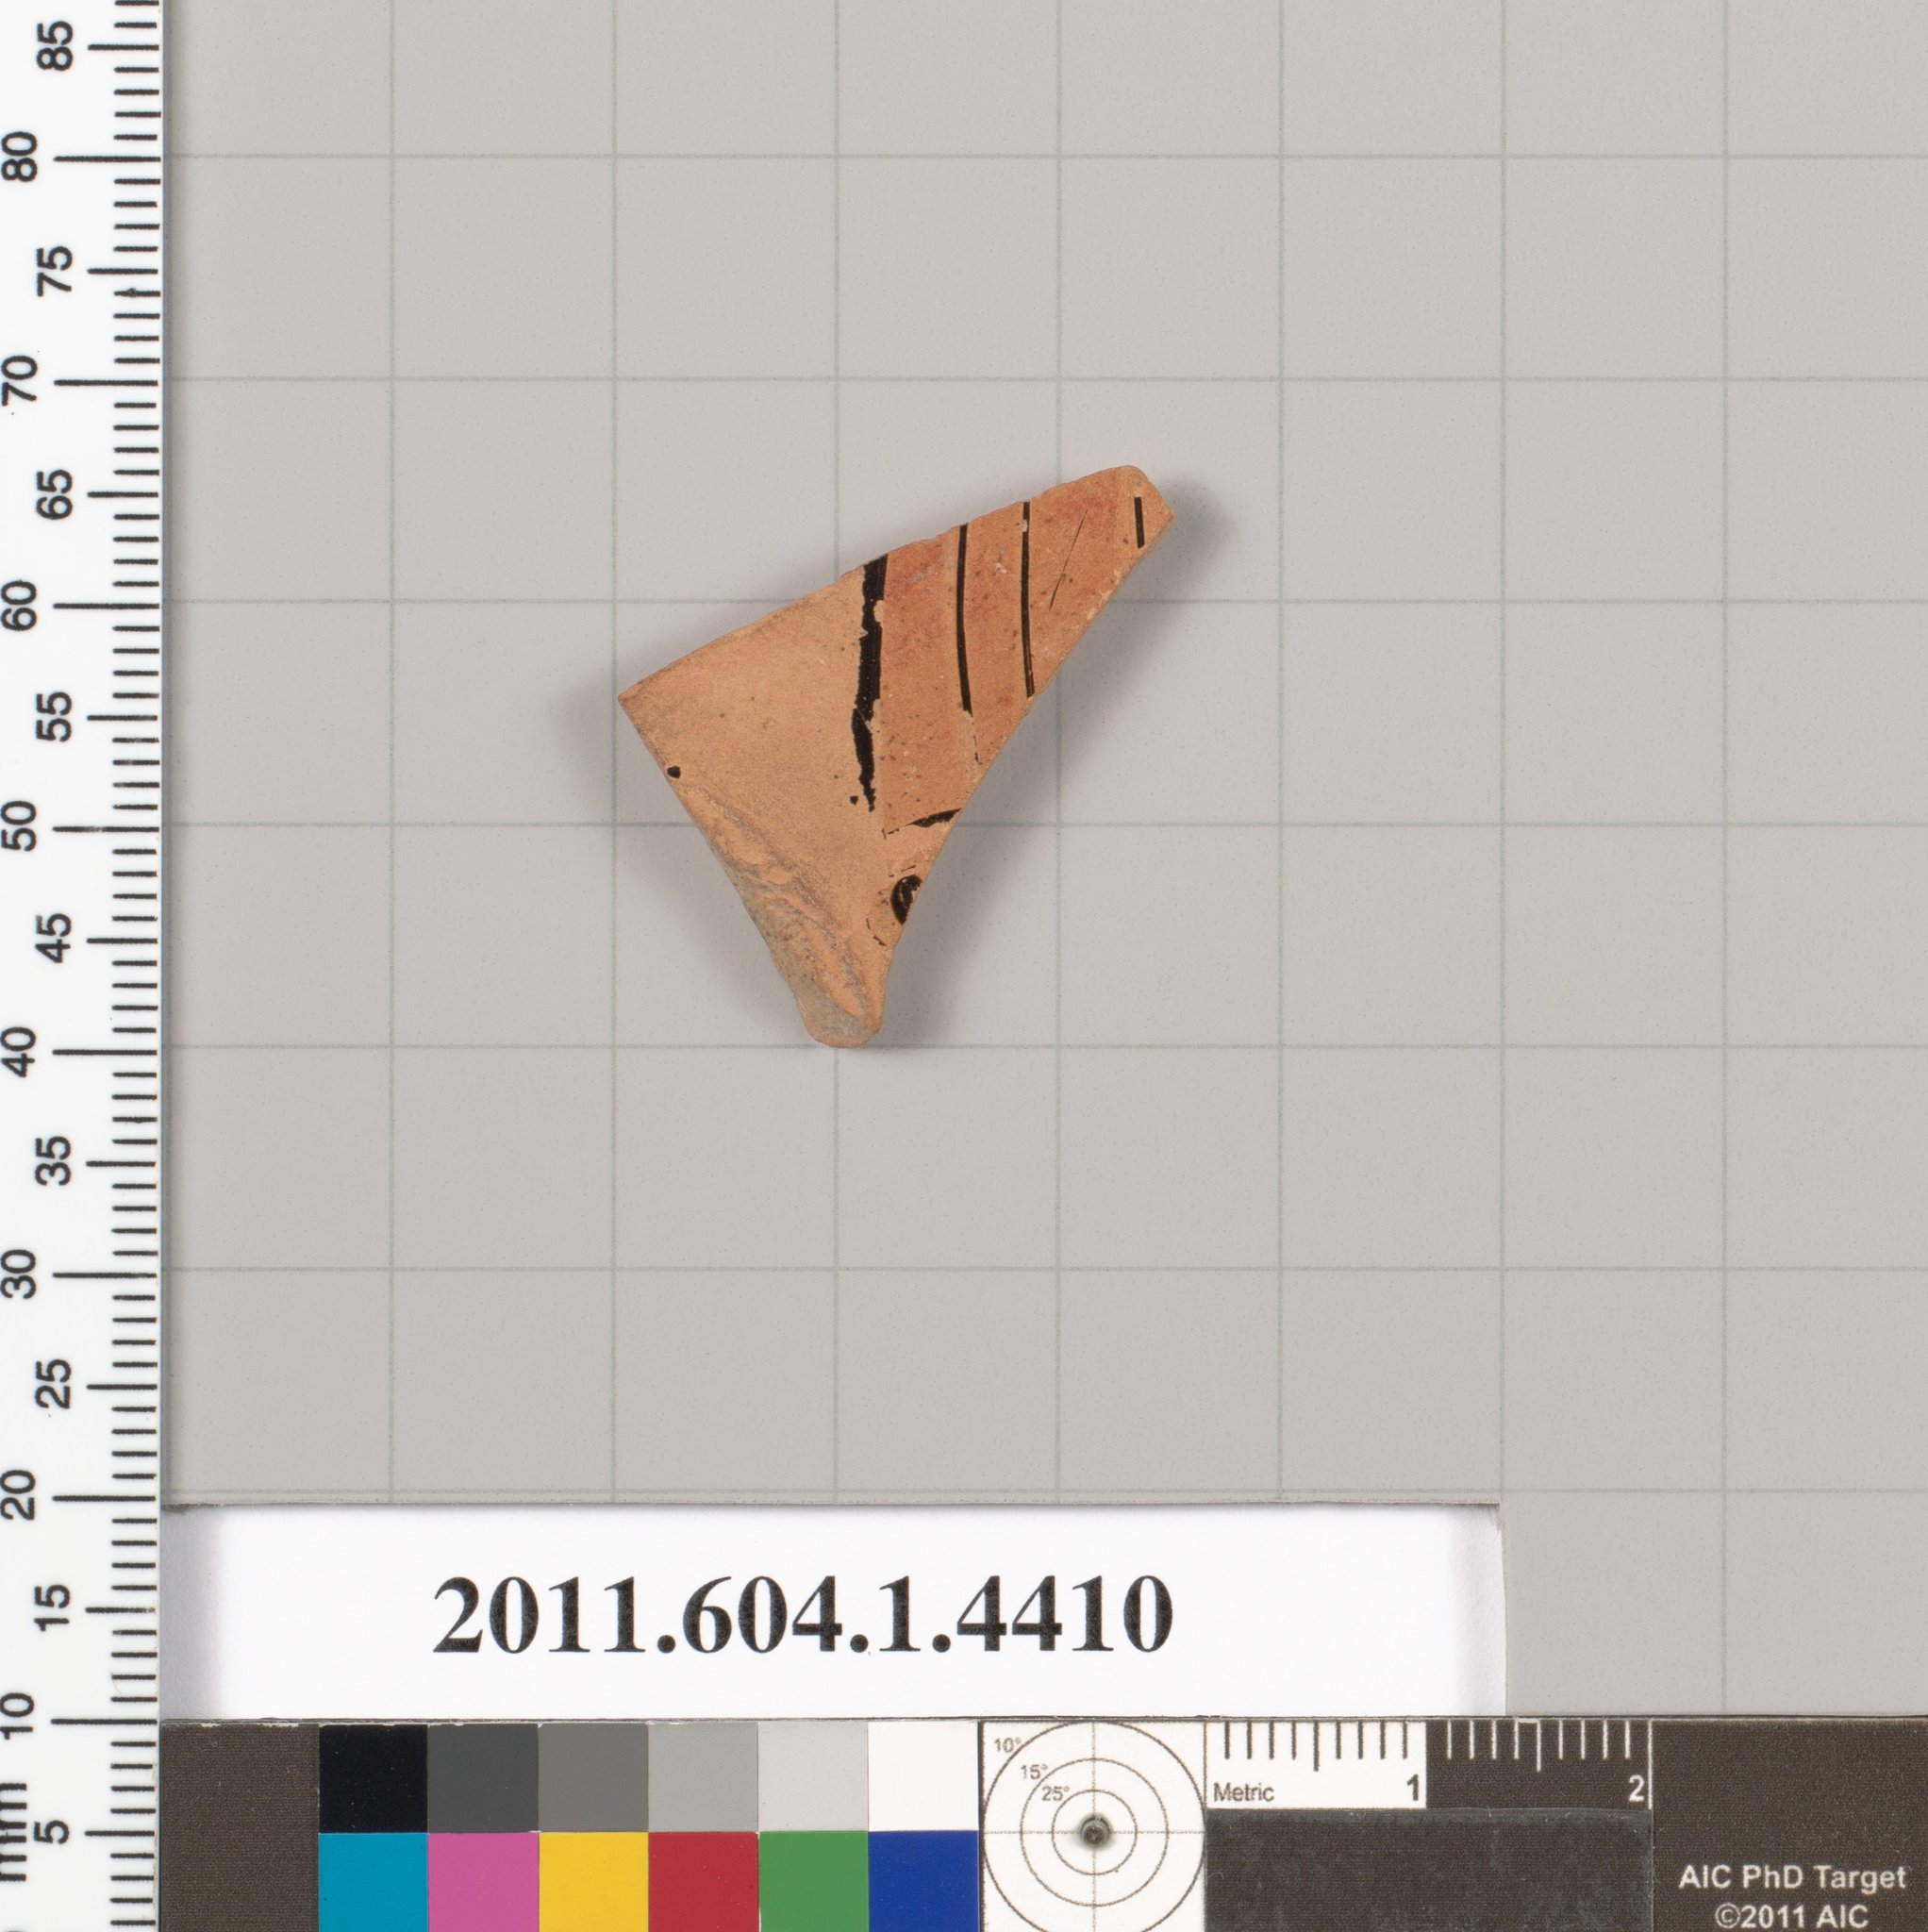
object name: kylix fragment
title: Terracotta fragment of a kylix (drinking cup)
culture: greek, attic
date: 475-451 BCE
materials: terracotta